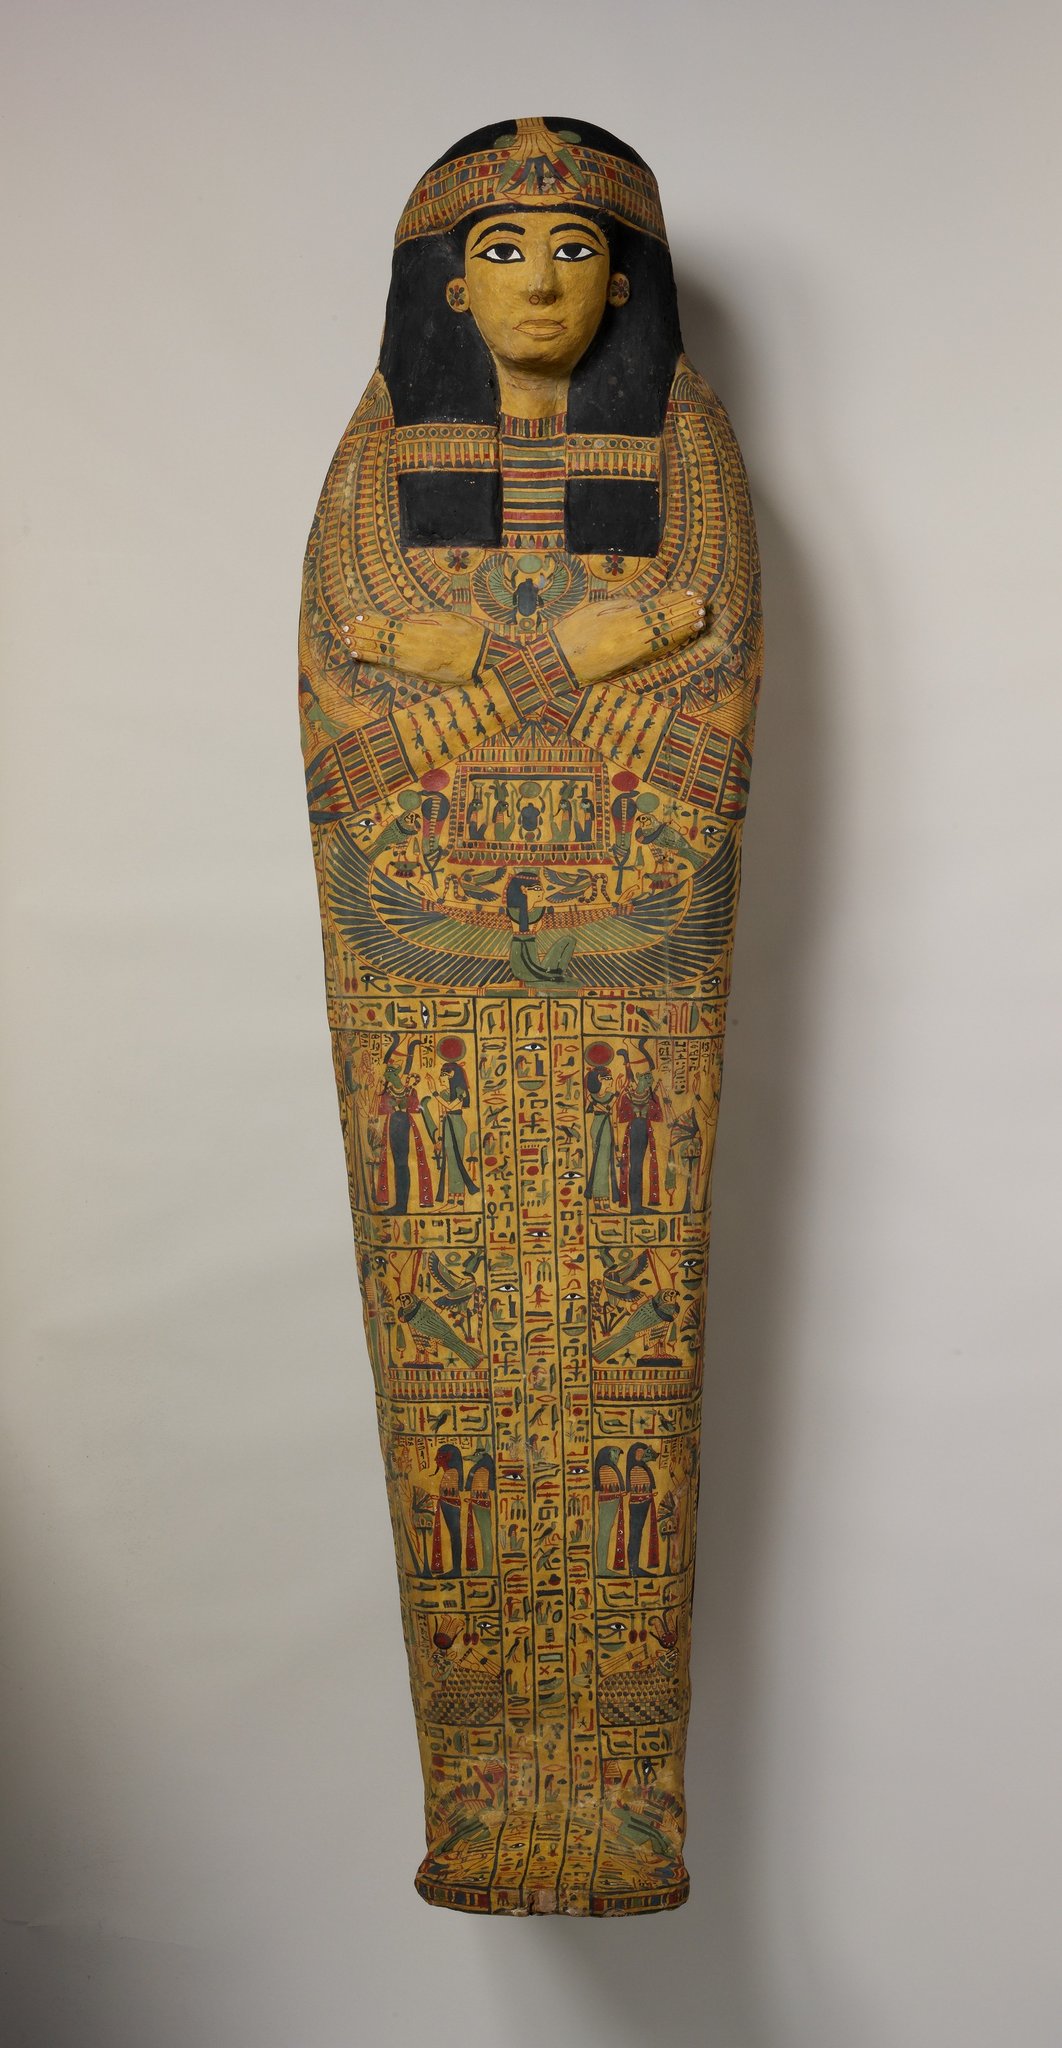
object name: coffin, ansenmes, singer of amun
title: Coffin of the Chantress of Amun Ansenmes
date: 1186-945 BCE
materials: paint, paste, wood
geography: egypt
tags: hieroglyphs,coffins